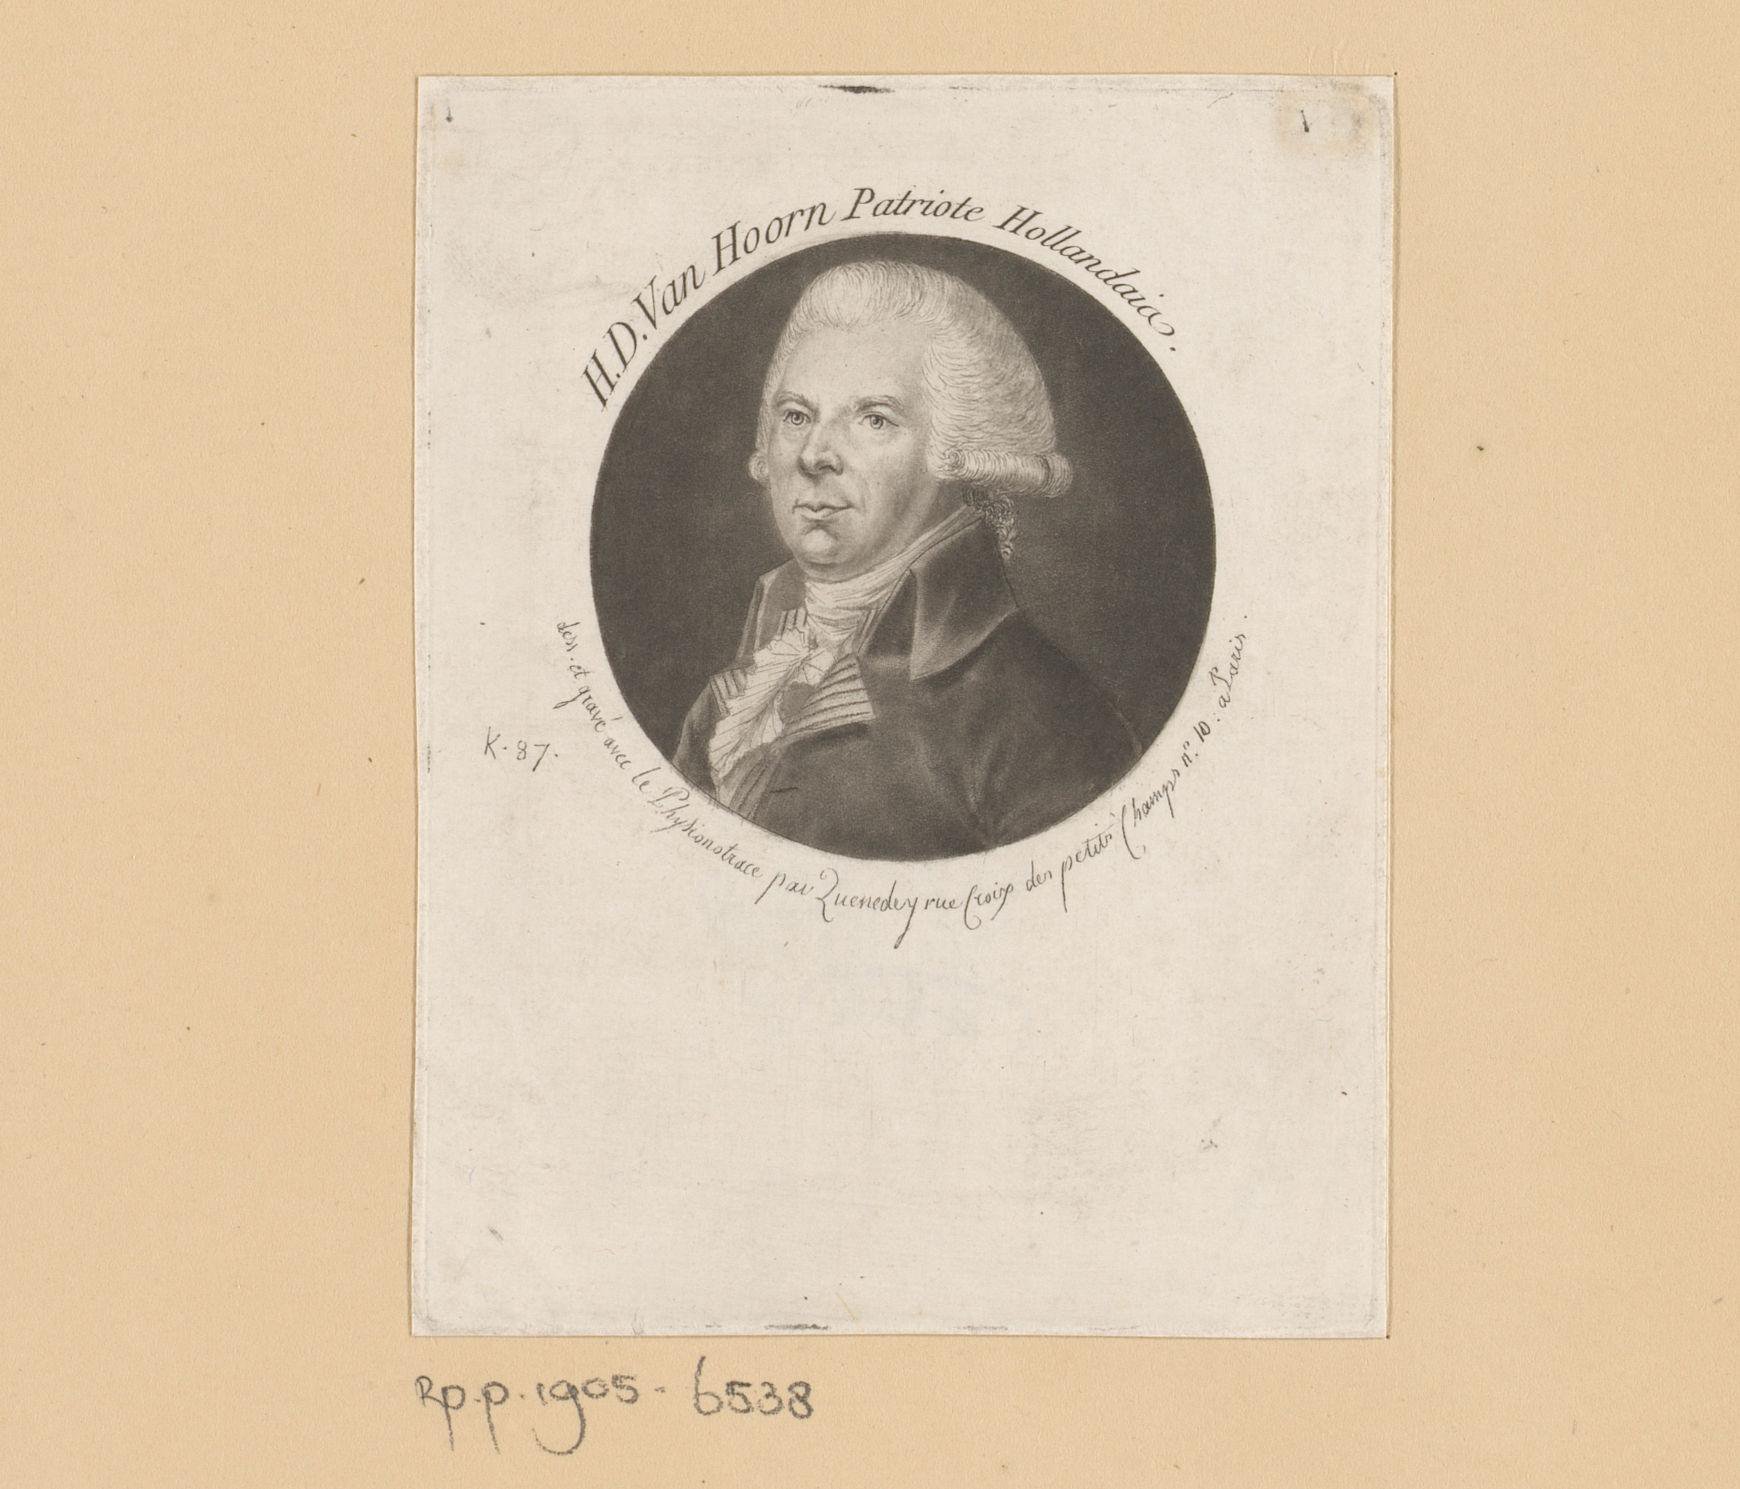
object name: print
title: H.D. van Hoorn patriote Hollandais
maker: edme quenedey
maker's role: print maker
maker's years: 1756-1830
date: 1785-1802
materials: paper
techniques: aquatint, etching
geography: paris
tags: amsterdam, politician, silhouette-apparatus, 'physionotrace', historical persons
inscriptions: collector's mark: Lugt 2228